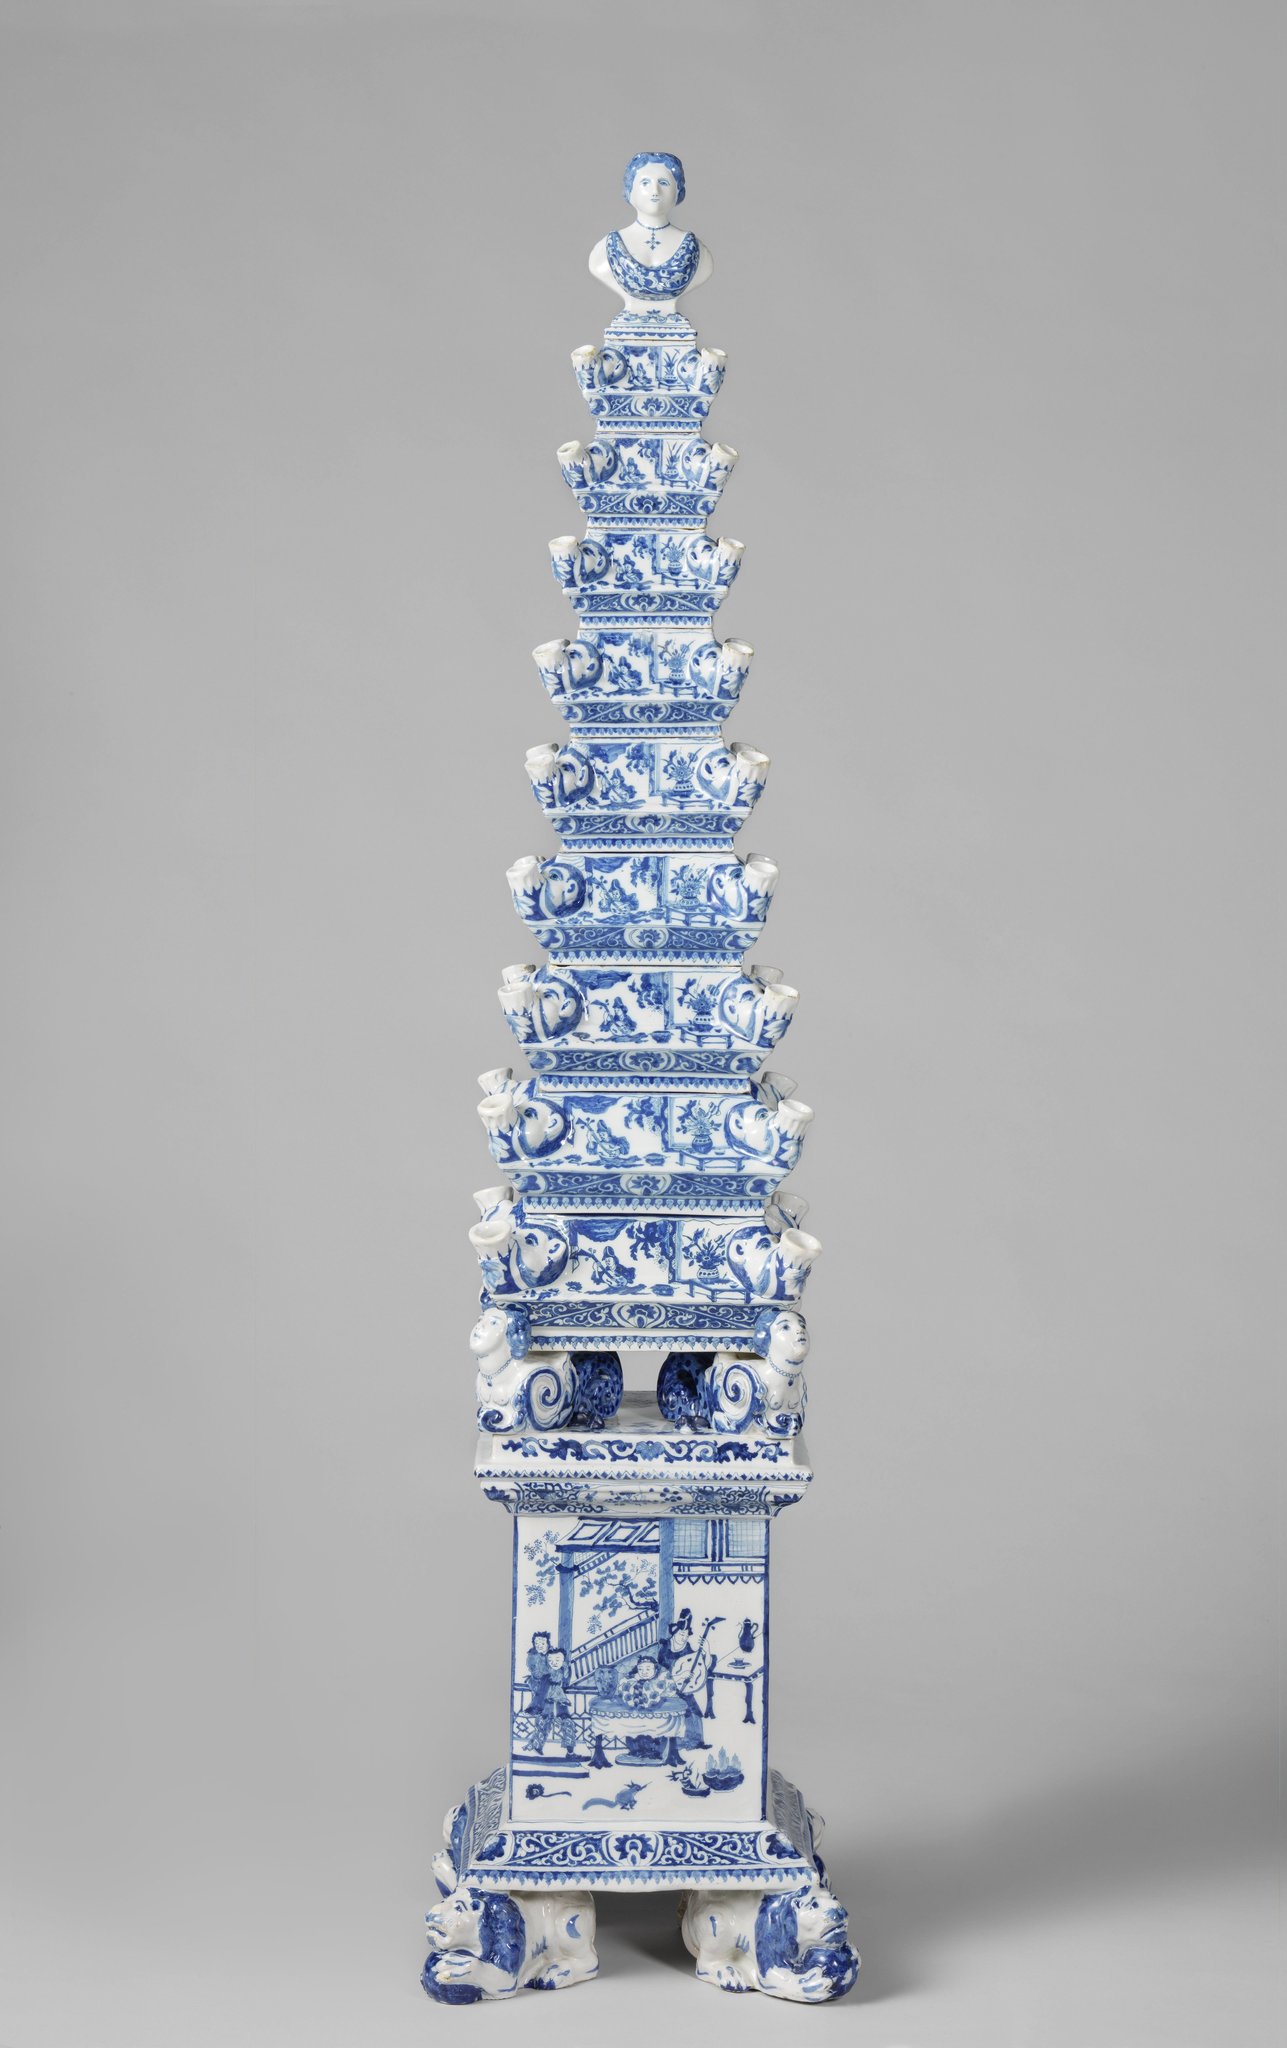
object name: bloempiramide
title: Flower pyramid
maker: lambertus van eenhoorn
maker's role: plateelbakker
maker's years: 1651-1721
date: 1692-1700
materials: faience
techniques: painted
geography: delft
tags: flowers, one person playing string instrument (plucked), beasts of prey, predatory animals: lion, chest, bust - aa - female human figure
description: Costly cut flowers could be placed in each spout of this flower pyramid, which is built up of separate elements. The model of this tall, stacked flower vase originated at the court of William and Mary, his consort, who was passionately interested in flower arrangement, porcelain and tin-glazed earthenware.